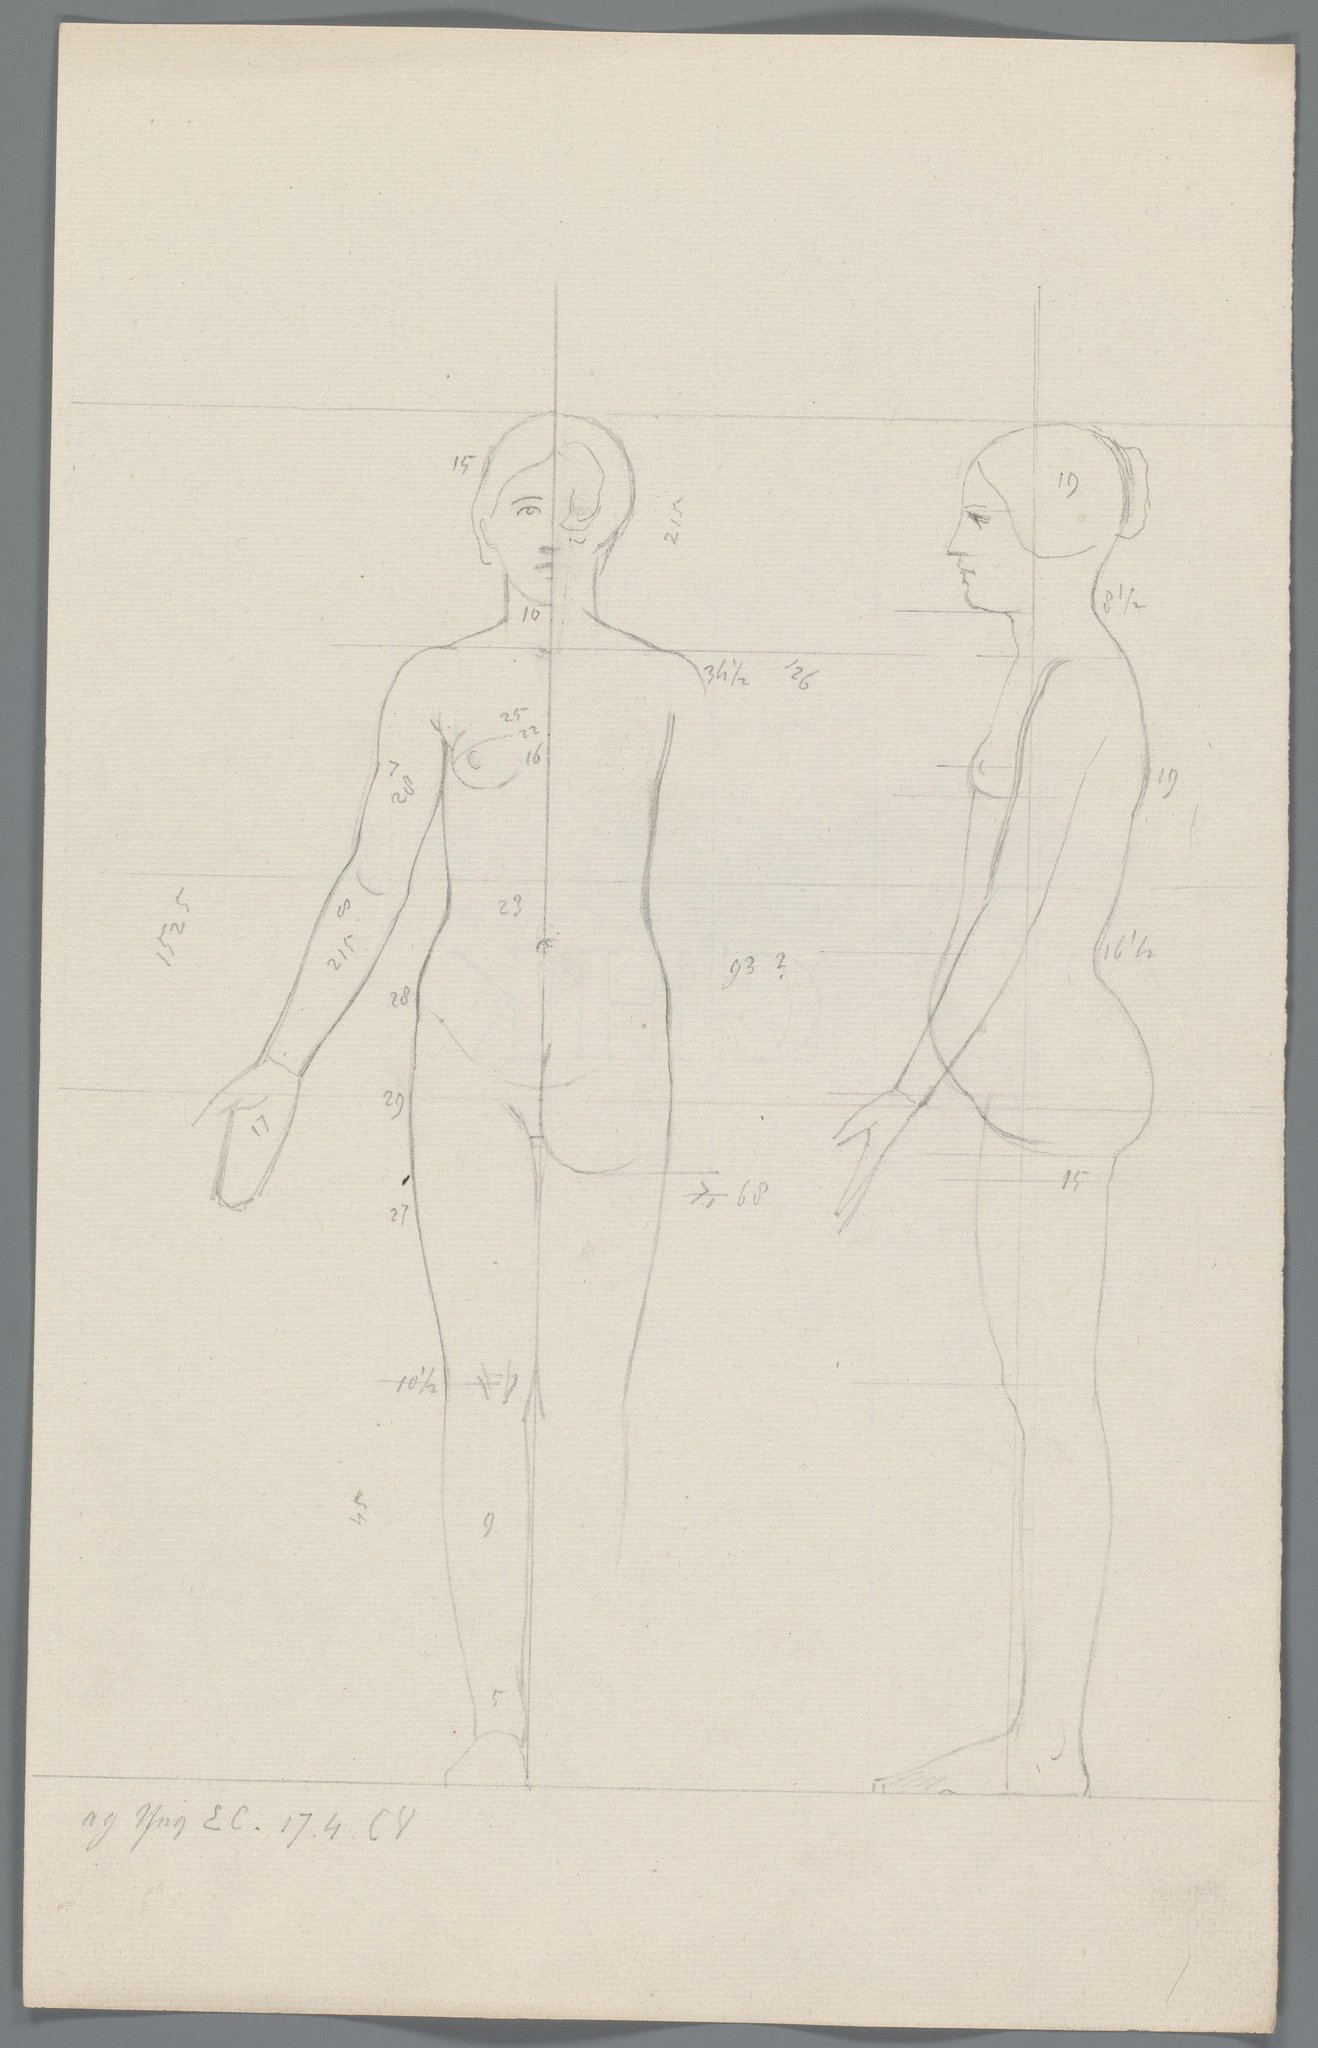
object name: drawing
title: Proportiestudie van een vrouw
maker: jacobus everhardus josephus van den berg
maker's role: draughtsman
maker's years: 1802-1861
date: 1853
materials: paper, pencil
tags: standing figure (canon, proportions) - aa - female human figure, anatomy (non-medical) - aa - female human figure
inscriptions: inscription: ‘ag Yng EC (...)’